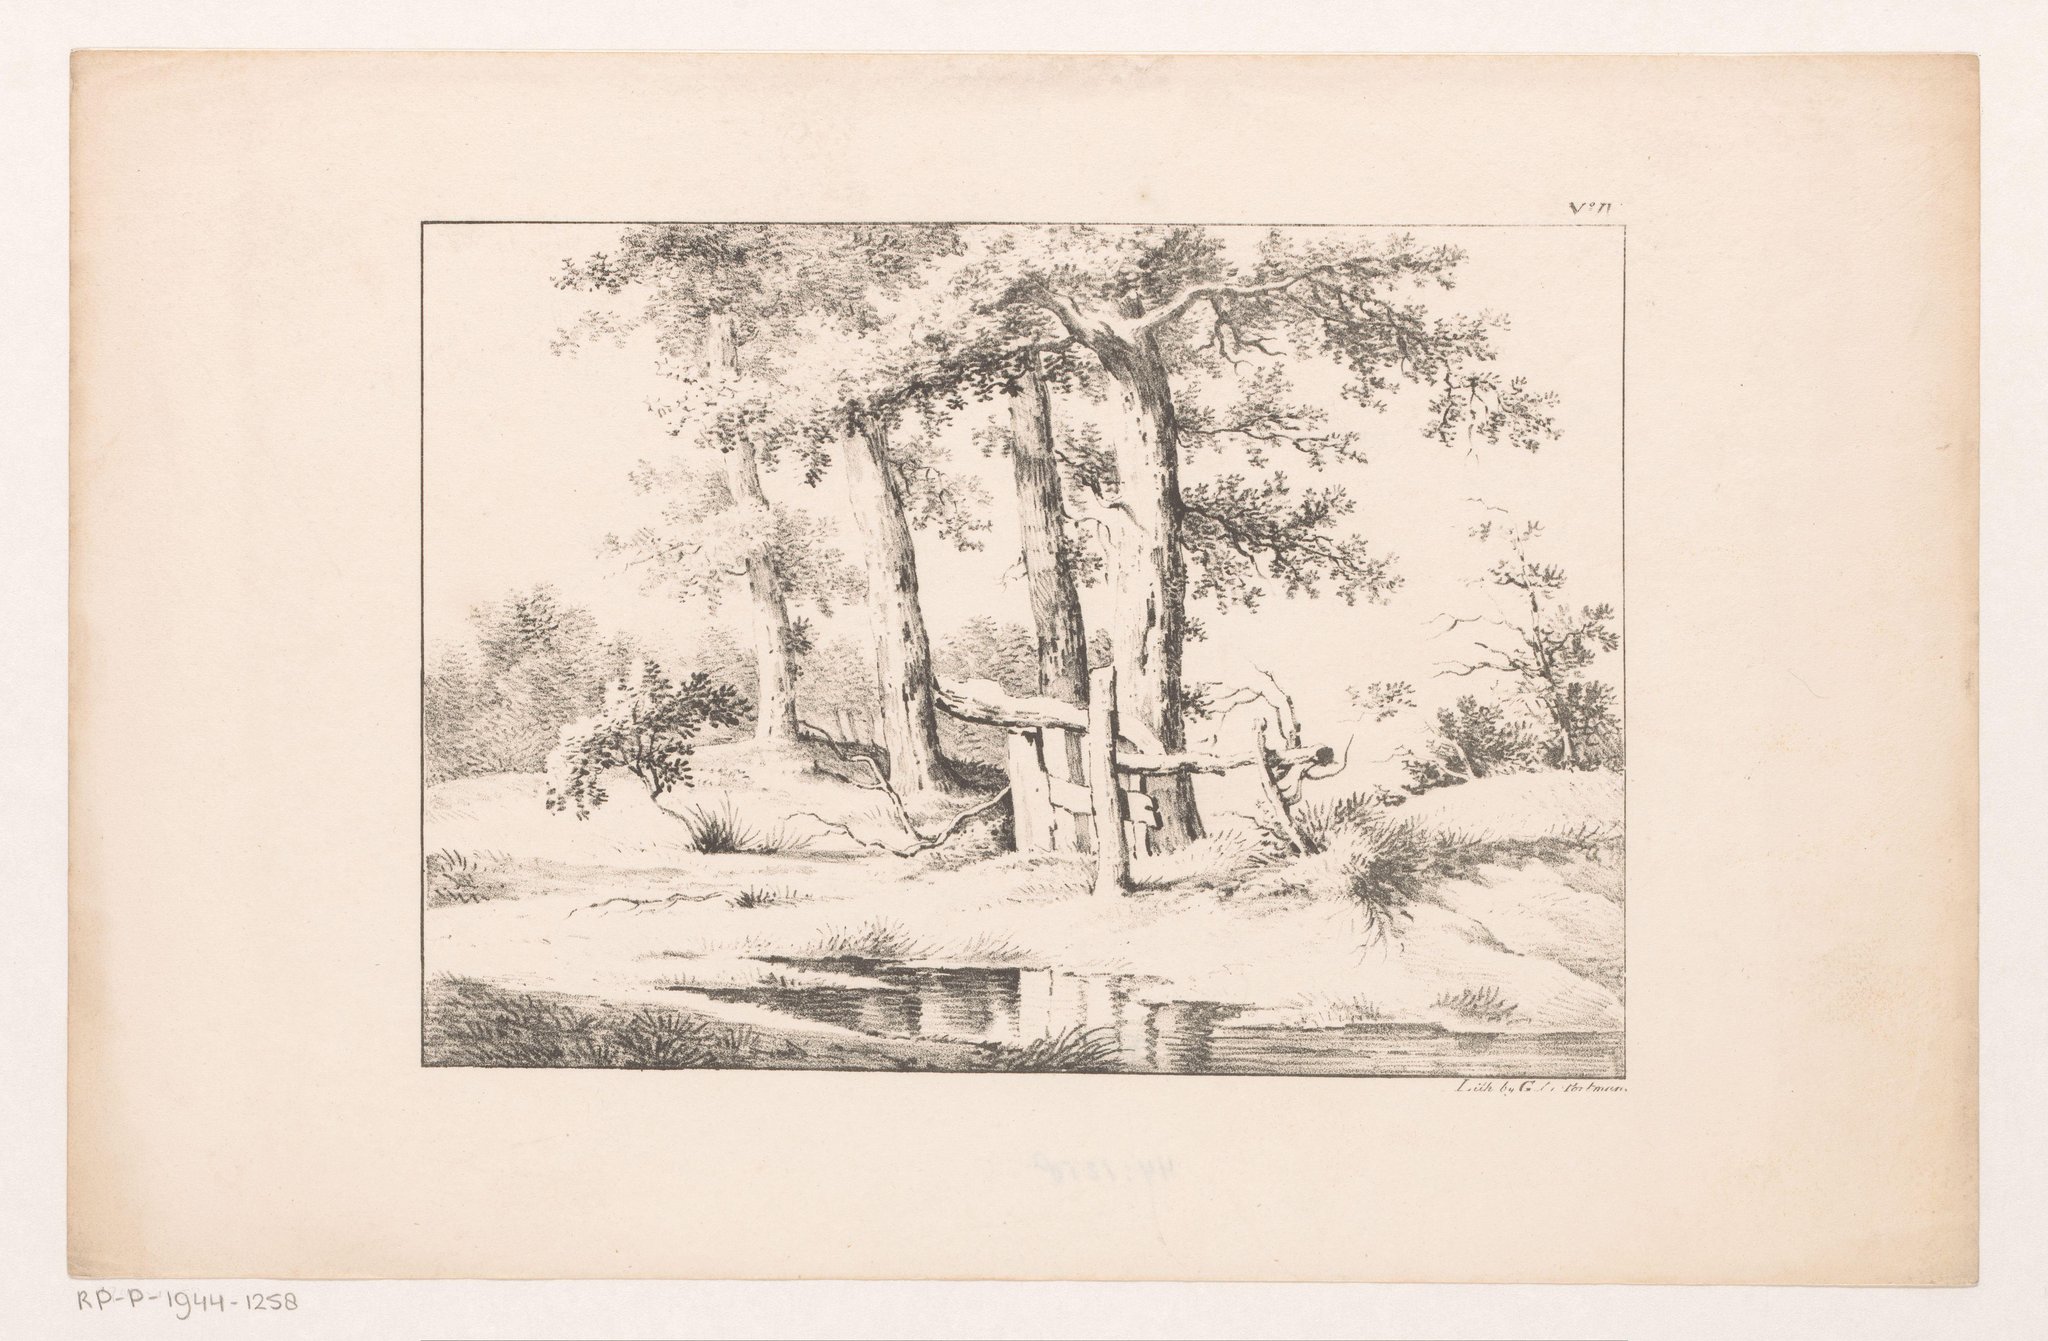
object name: print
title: Vier bomen met hek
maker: Anonymous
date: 1827-1828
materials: paper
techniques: lithograph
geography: amsterdam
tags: trees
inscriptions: collector's mark: Lugt 2228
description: Een landschap met vier bomen waarbij een hek, rechtsvoor een plas.